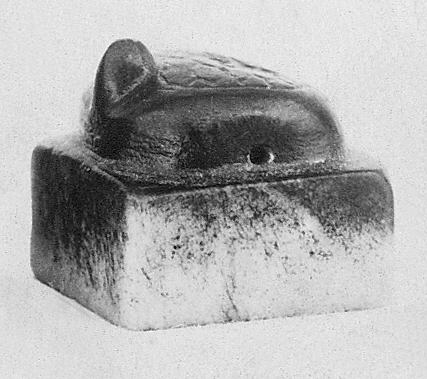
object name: seal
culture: chinese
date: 206 BCE-220 CE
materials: jade